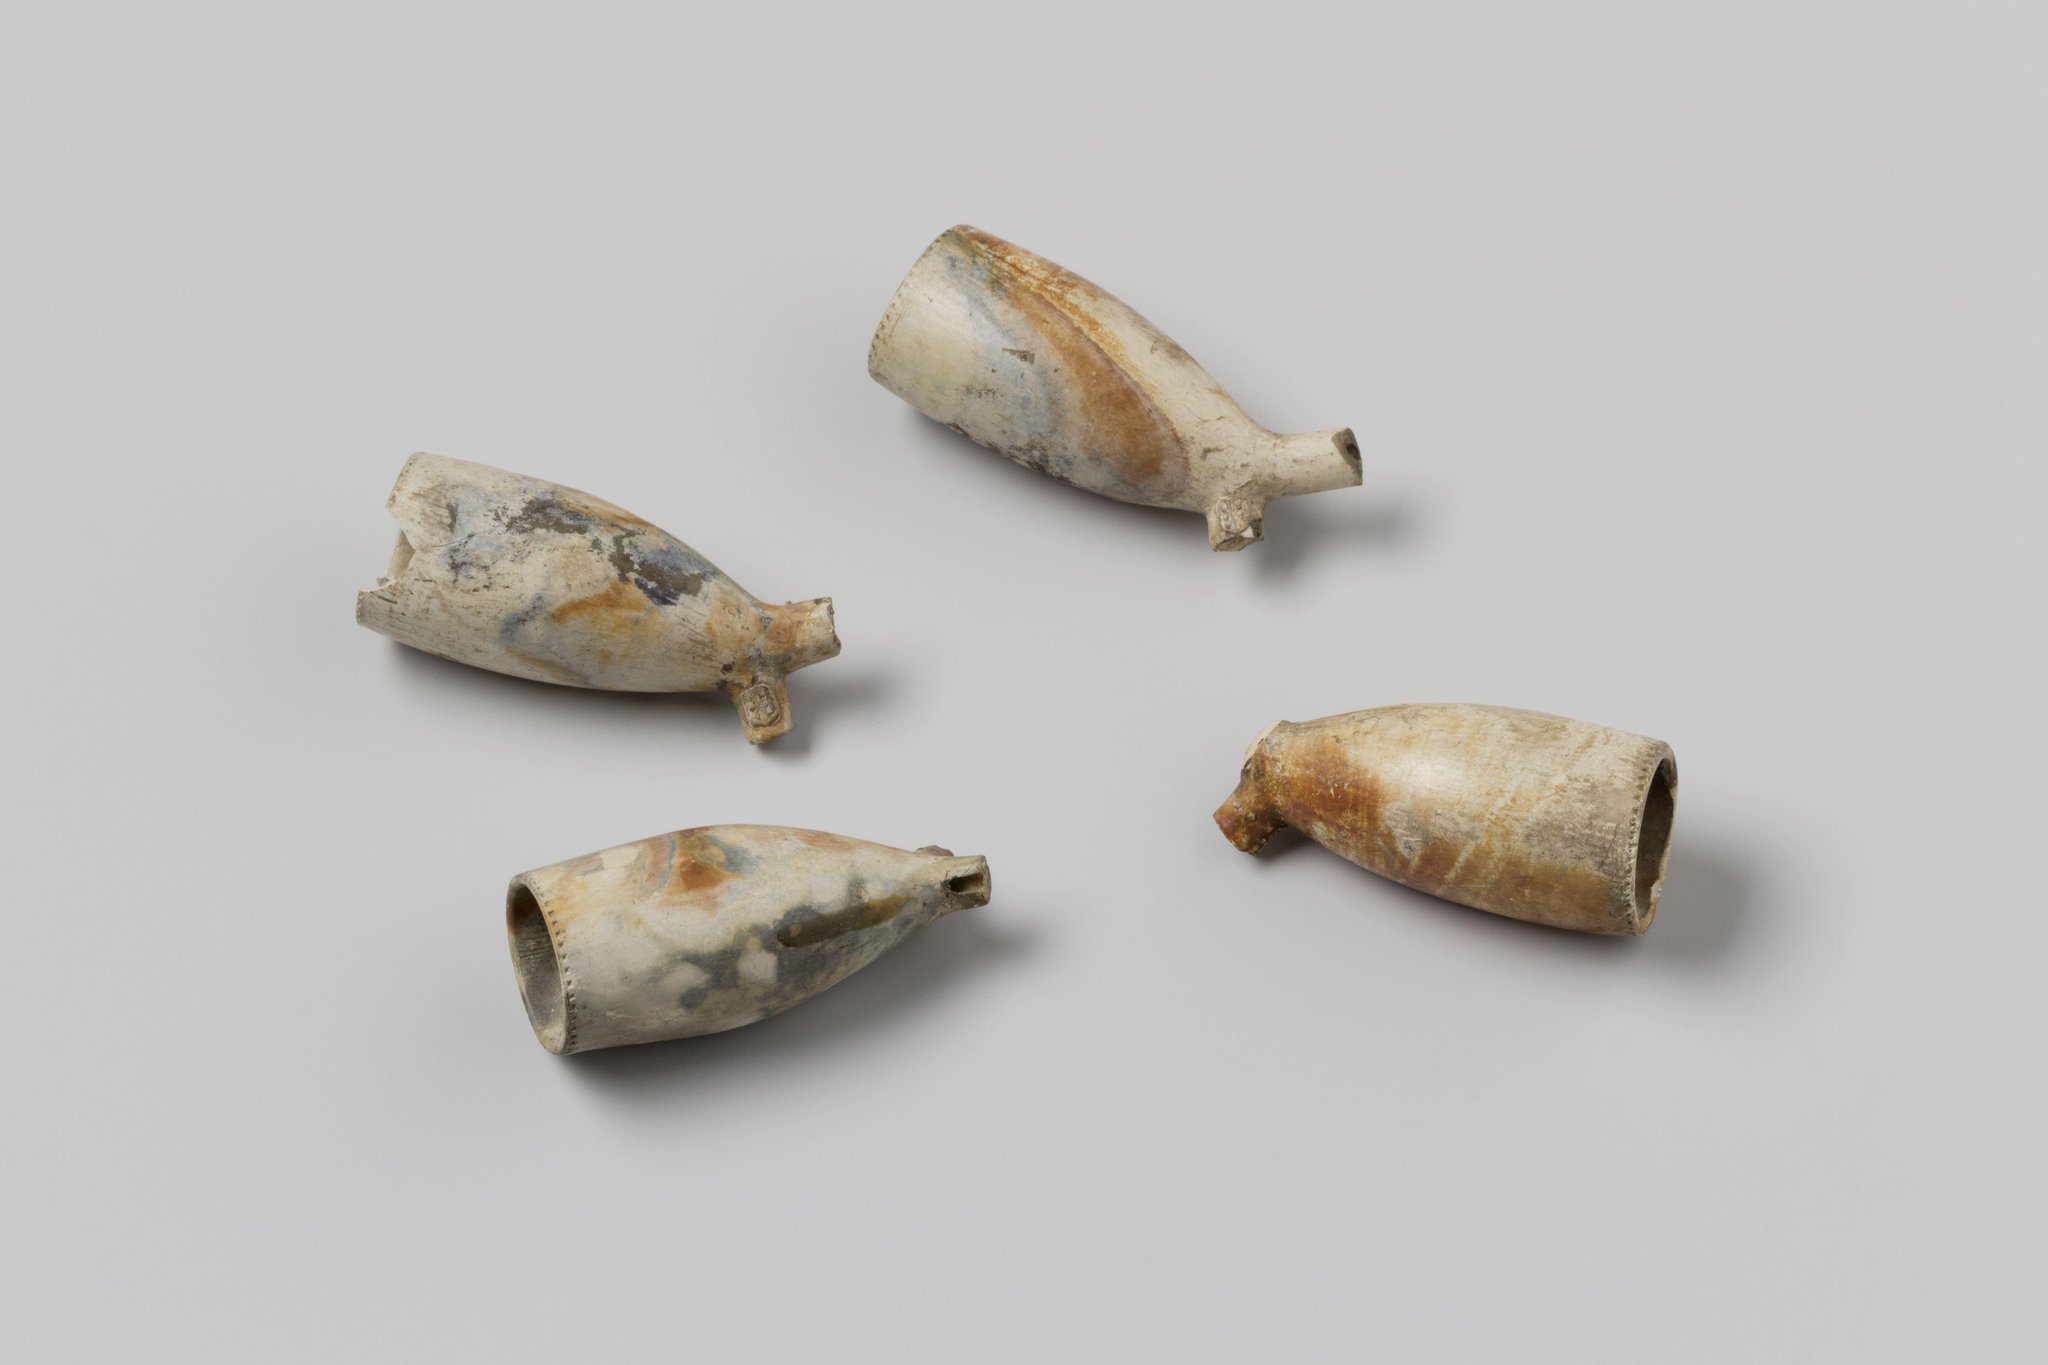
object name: pipe bowl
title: Pijpenkoppen uit het wrak van de Oost-Indiëvaarder Hollandia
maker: Anonymous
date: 1700-1743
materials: clay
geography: netherlands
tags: verenigde oostindische compagnie, hollandia (schip), annet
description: Pipe, bowl, heelmark: fish, flounder; fragm, 2hsm1,4, 1hsm1.